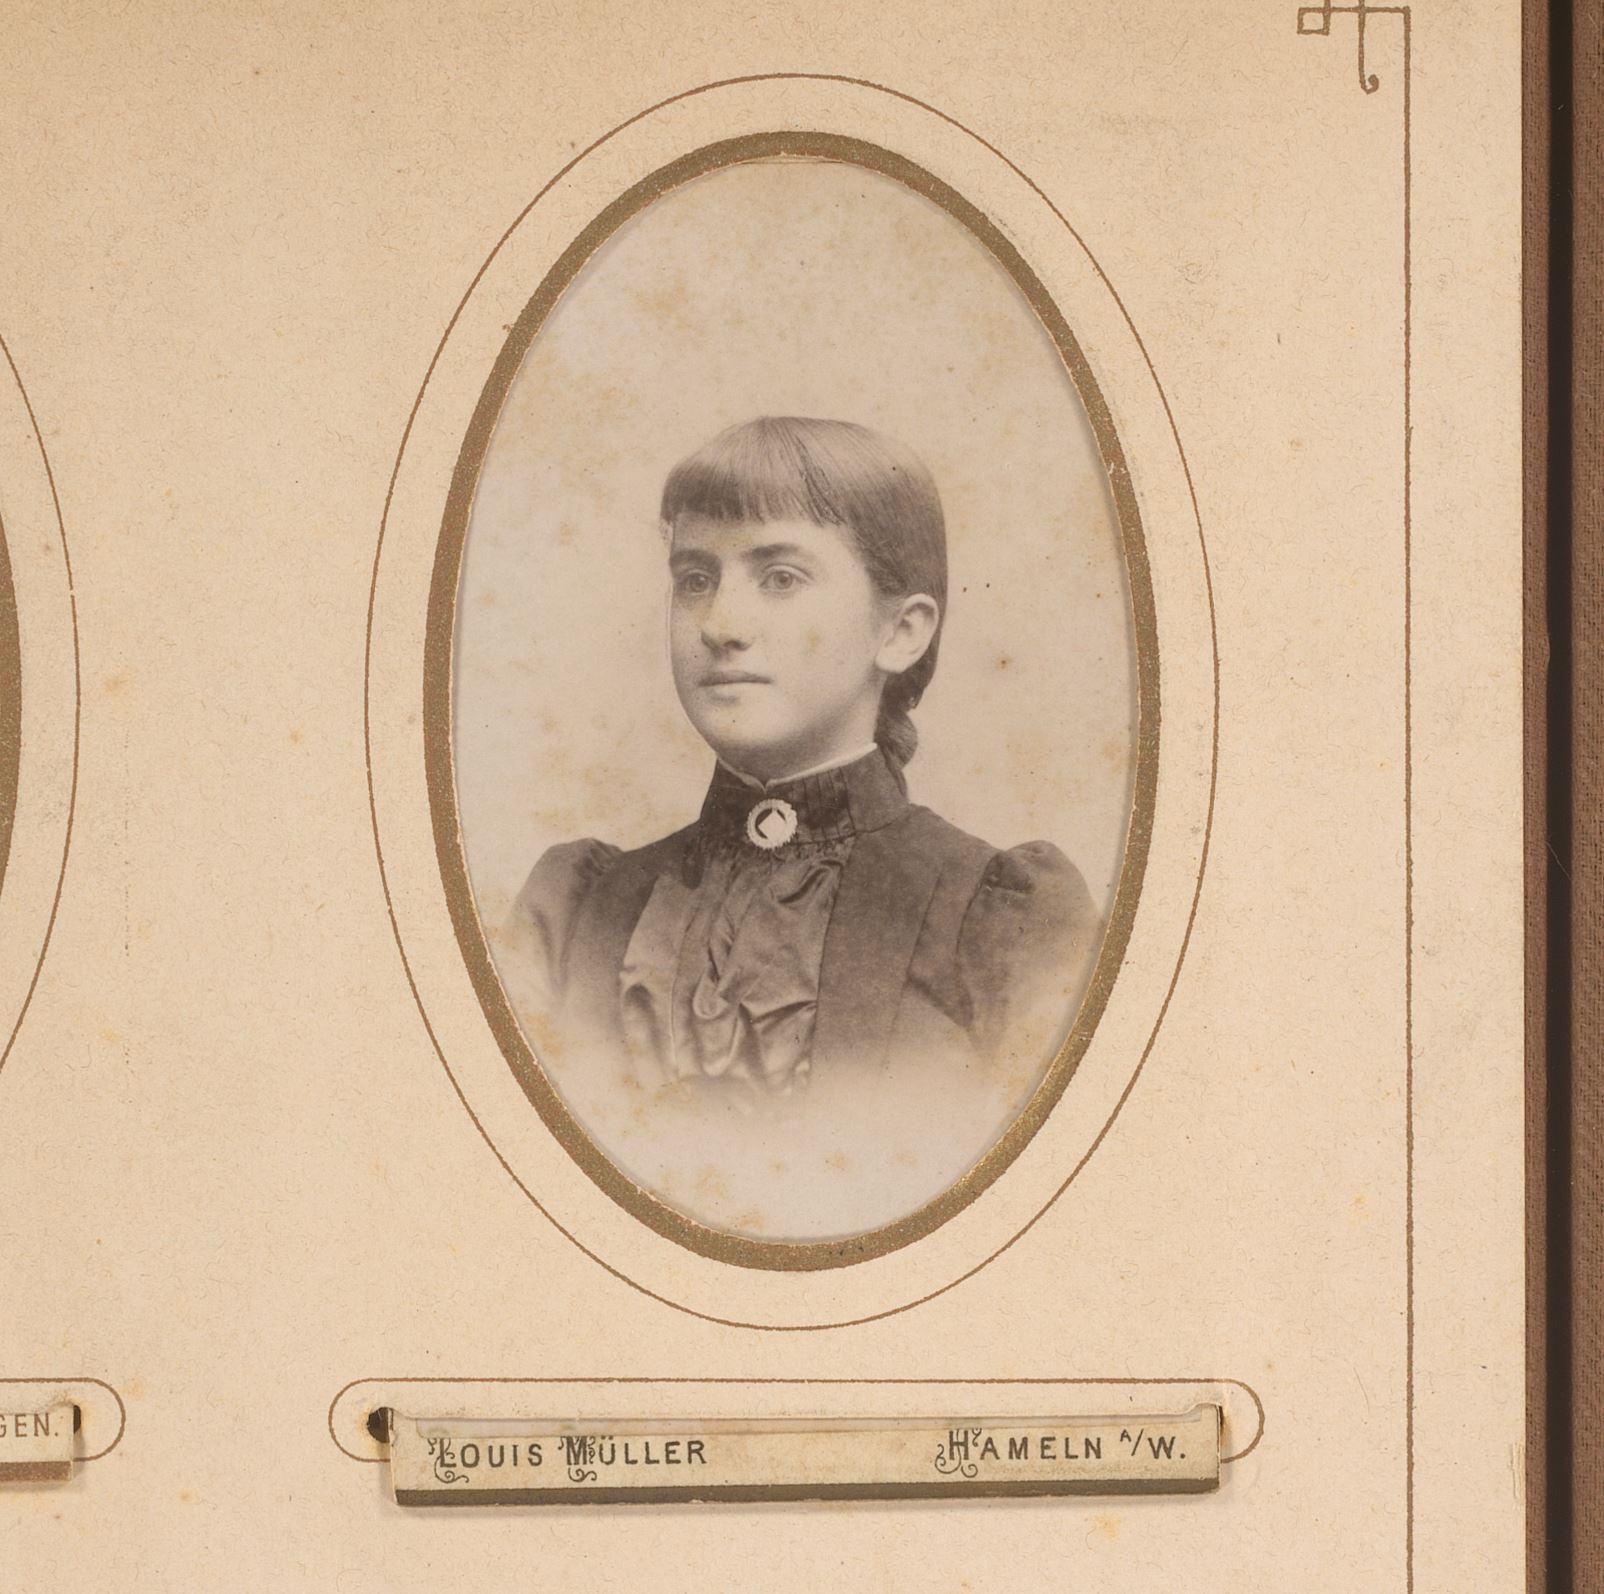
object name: photograph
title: Portret van een jonge vrouw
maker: louis müller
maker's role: fotograaf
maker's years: 1853-1912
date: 1886-1912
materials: cardboard, photographic support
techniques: albumen print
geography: hameln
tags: adolescent, young woman, maiden, historical persons - bb - woman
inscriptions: inscription: ‘Louis Müller/ Hameln a/ W’